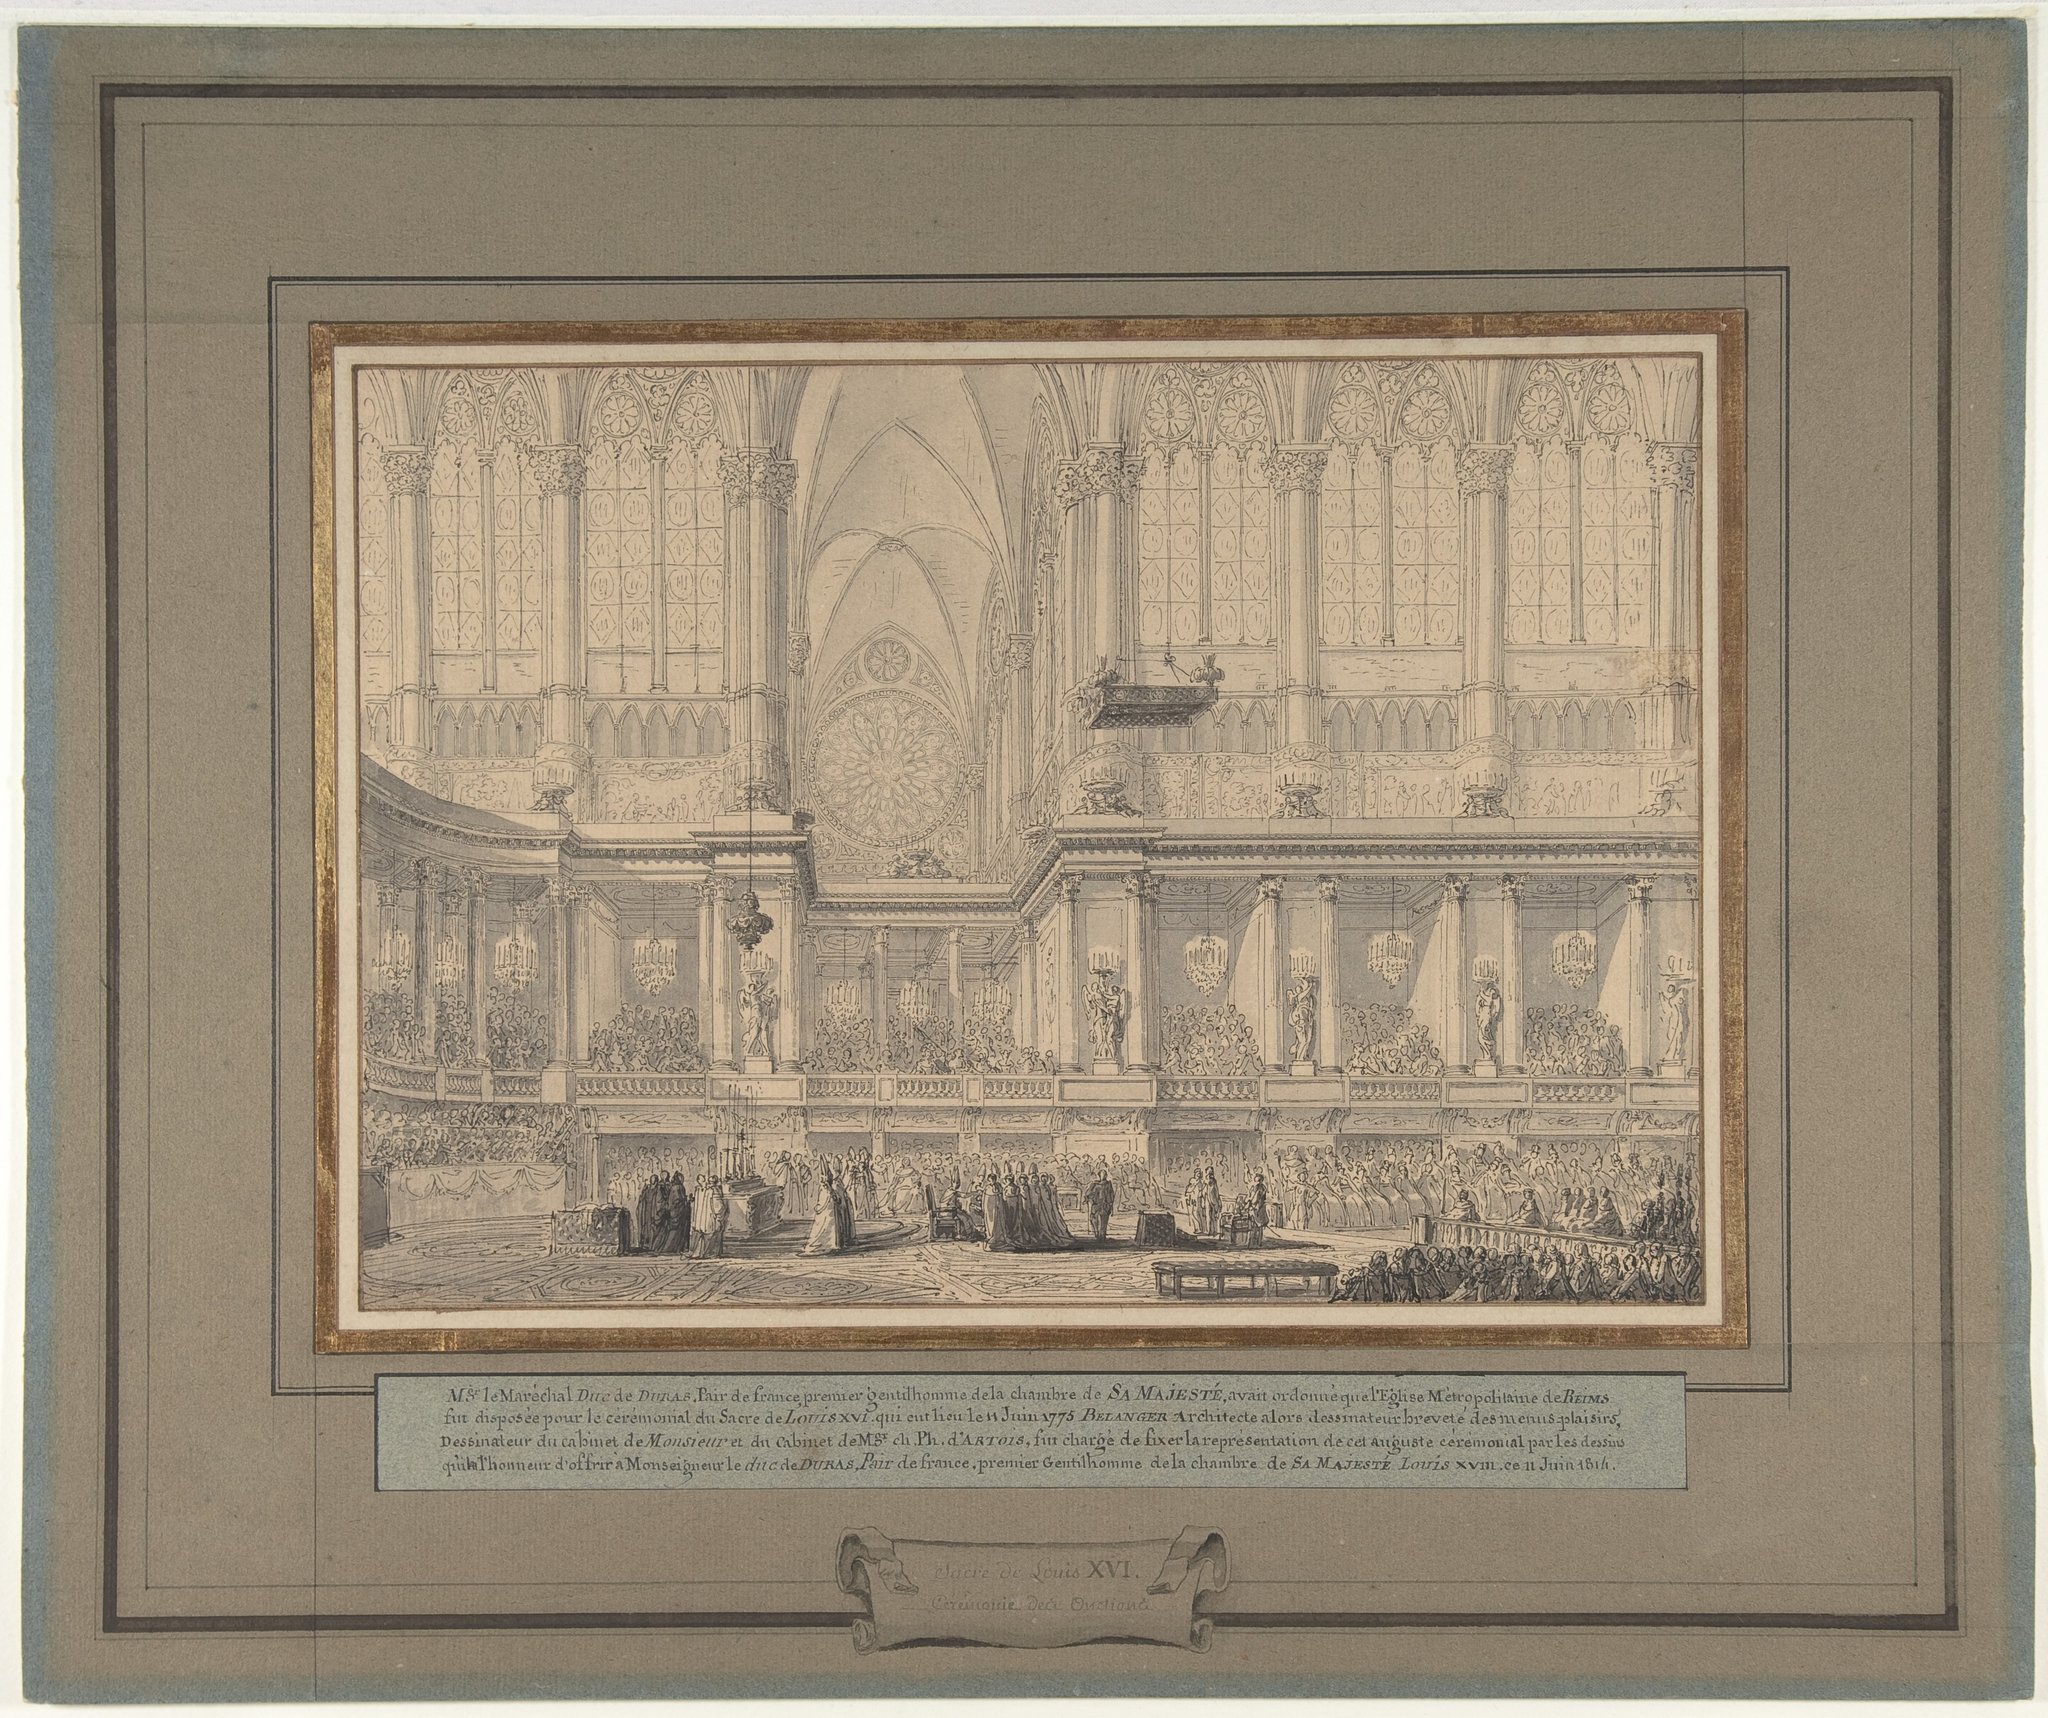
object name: drawing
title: The Anointing of Louis XVI at His Coronation in Reims Cathedral, June 11, 1775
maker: françois joseph belanger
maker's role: artist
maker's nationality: french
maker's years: 1744-1818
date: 1814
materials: ink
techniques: brush, pen, wash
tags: cathedrals,louis xvi,ceremony,crowd